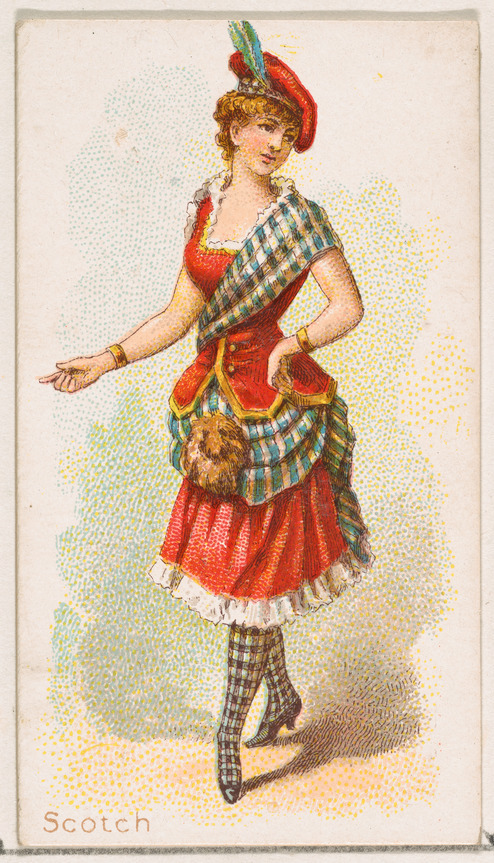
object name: print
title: Scotch Dancer, from the Dancing Women series (N186) issued by Wm. S. Kimball & Co.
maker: william s. kimball & company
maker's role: publisher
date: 1889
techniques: color lithograph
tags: women,dancing,dancers